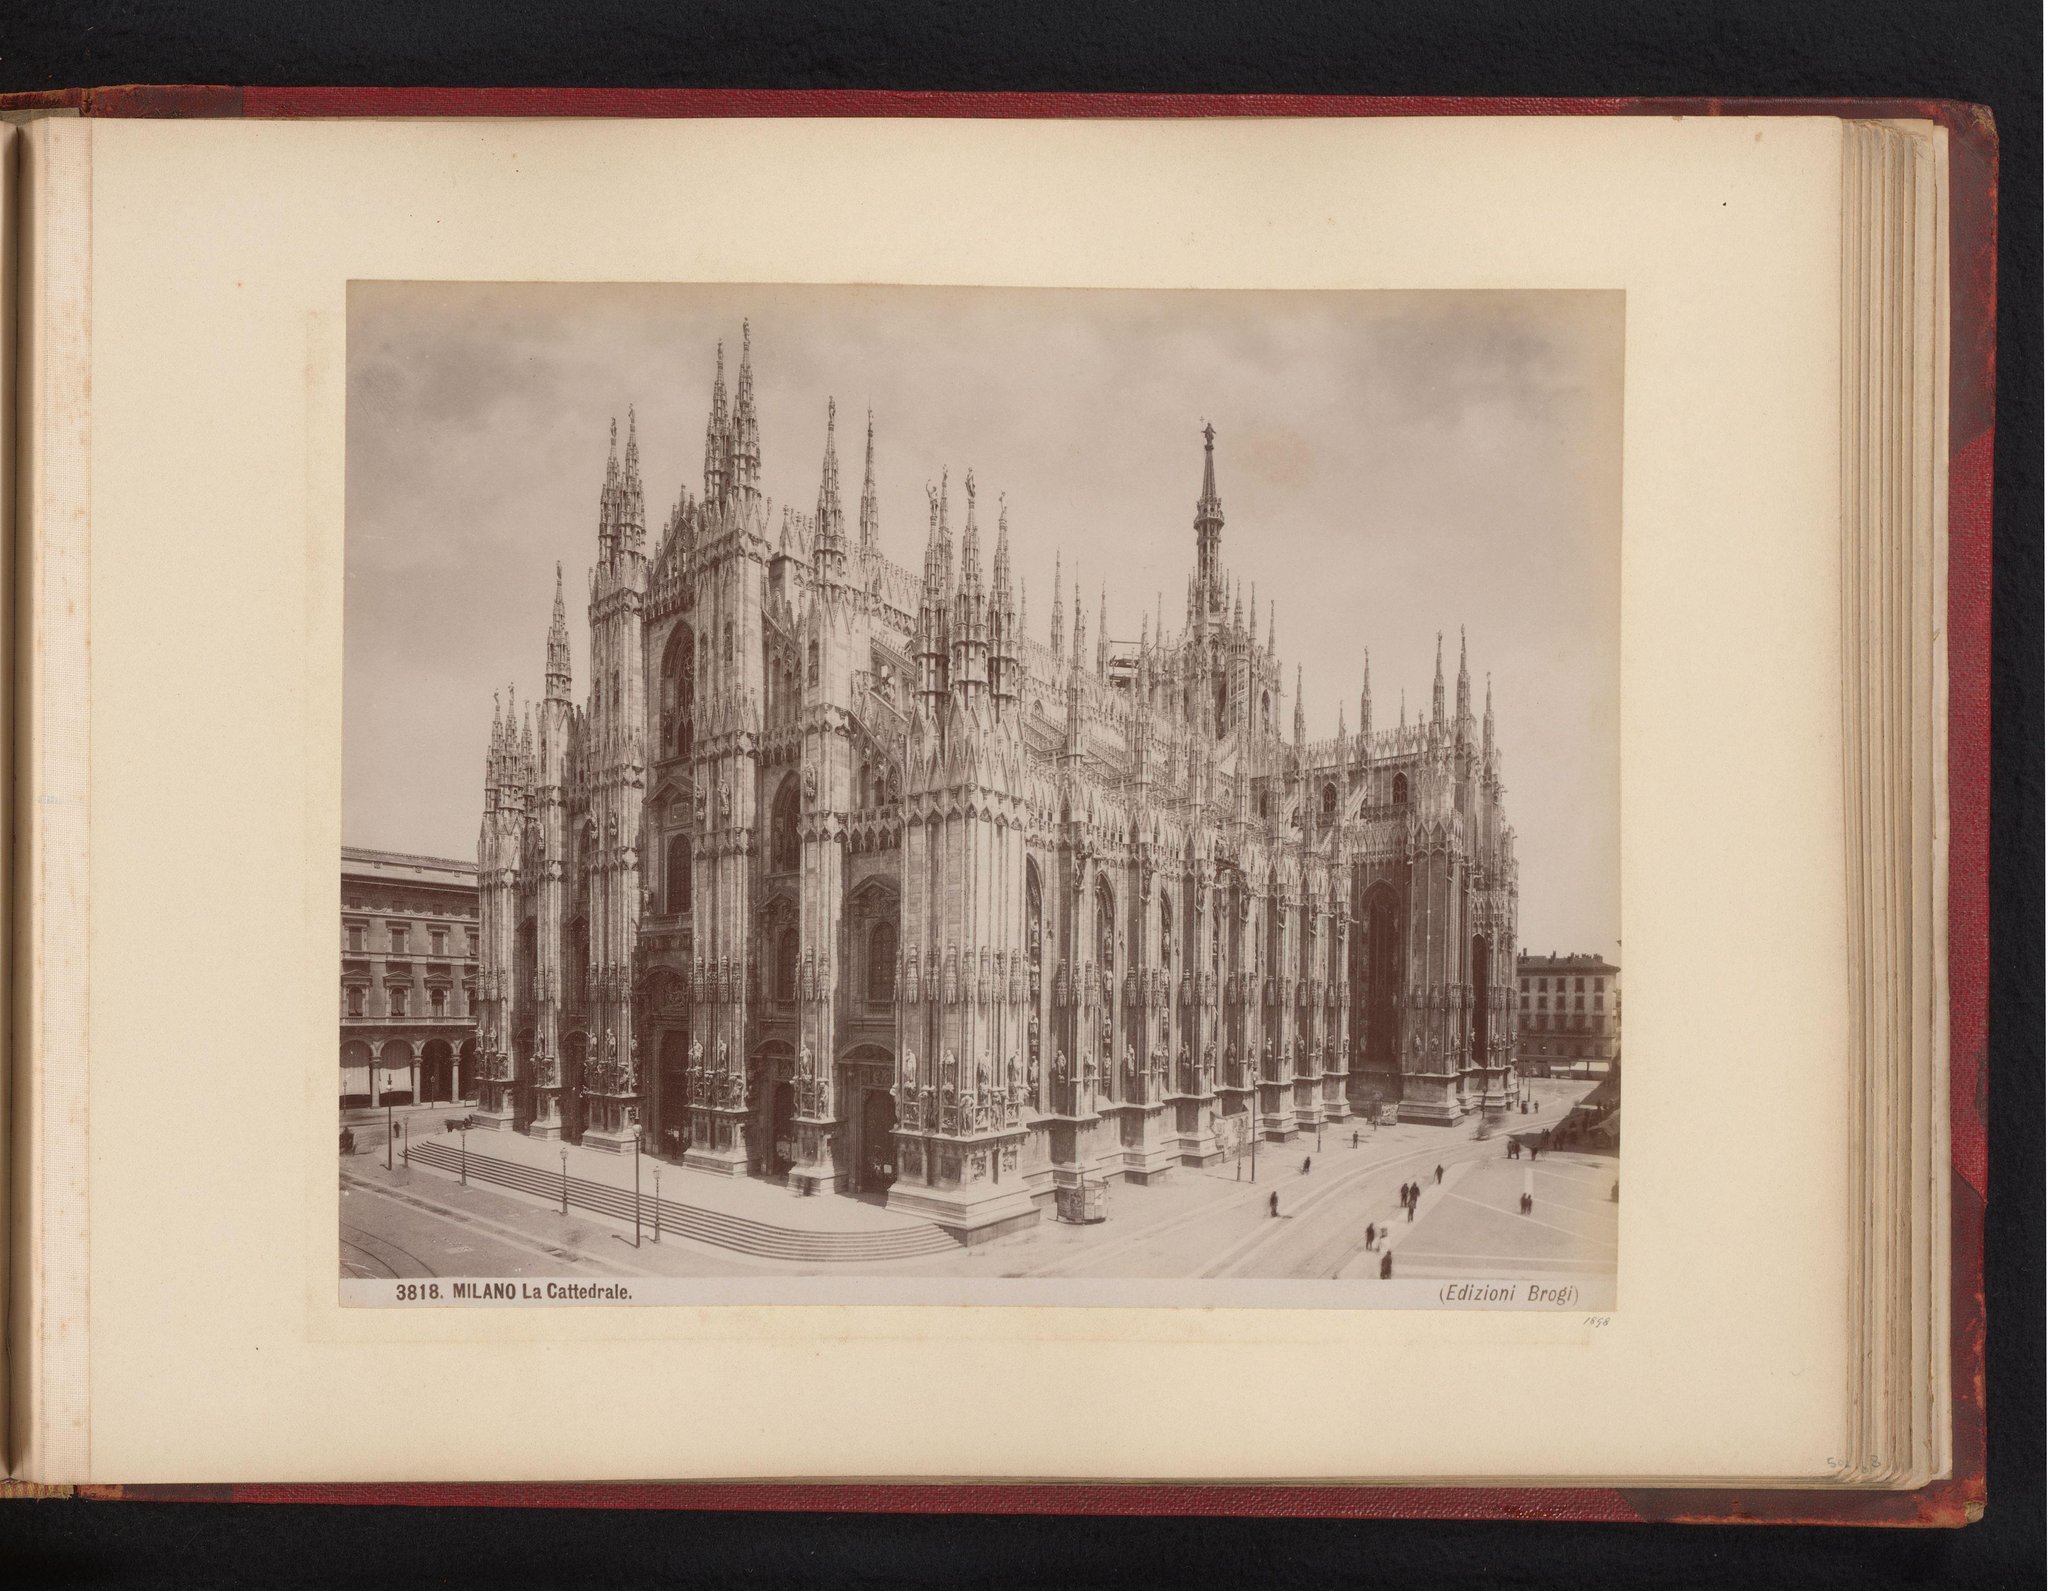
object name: photograph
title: Dom van Milaan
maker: Anonymous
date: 1898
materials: photographic support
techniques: albumen print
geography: italy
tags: church (exterior)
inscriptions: date